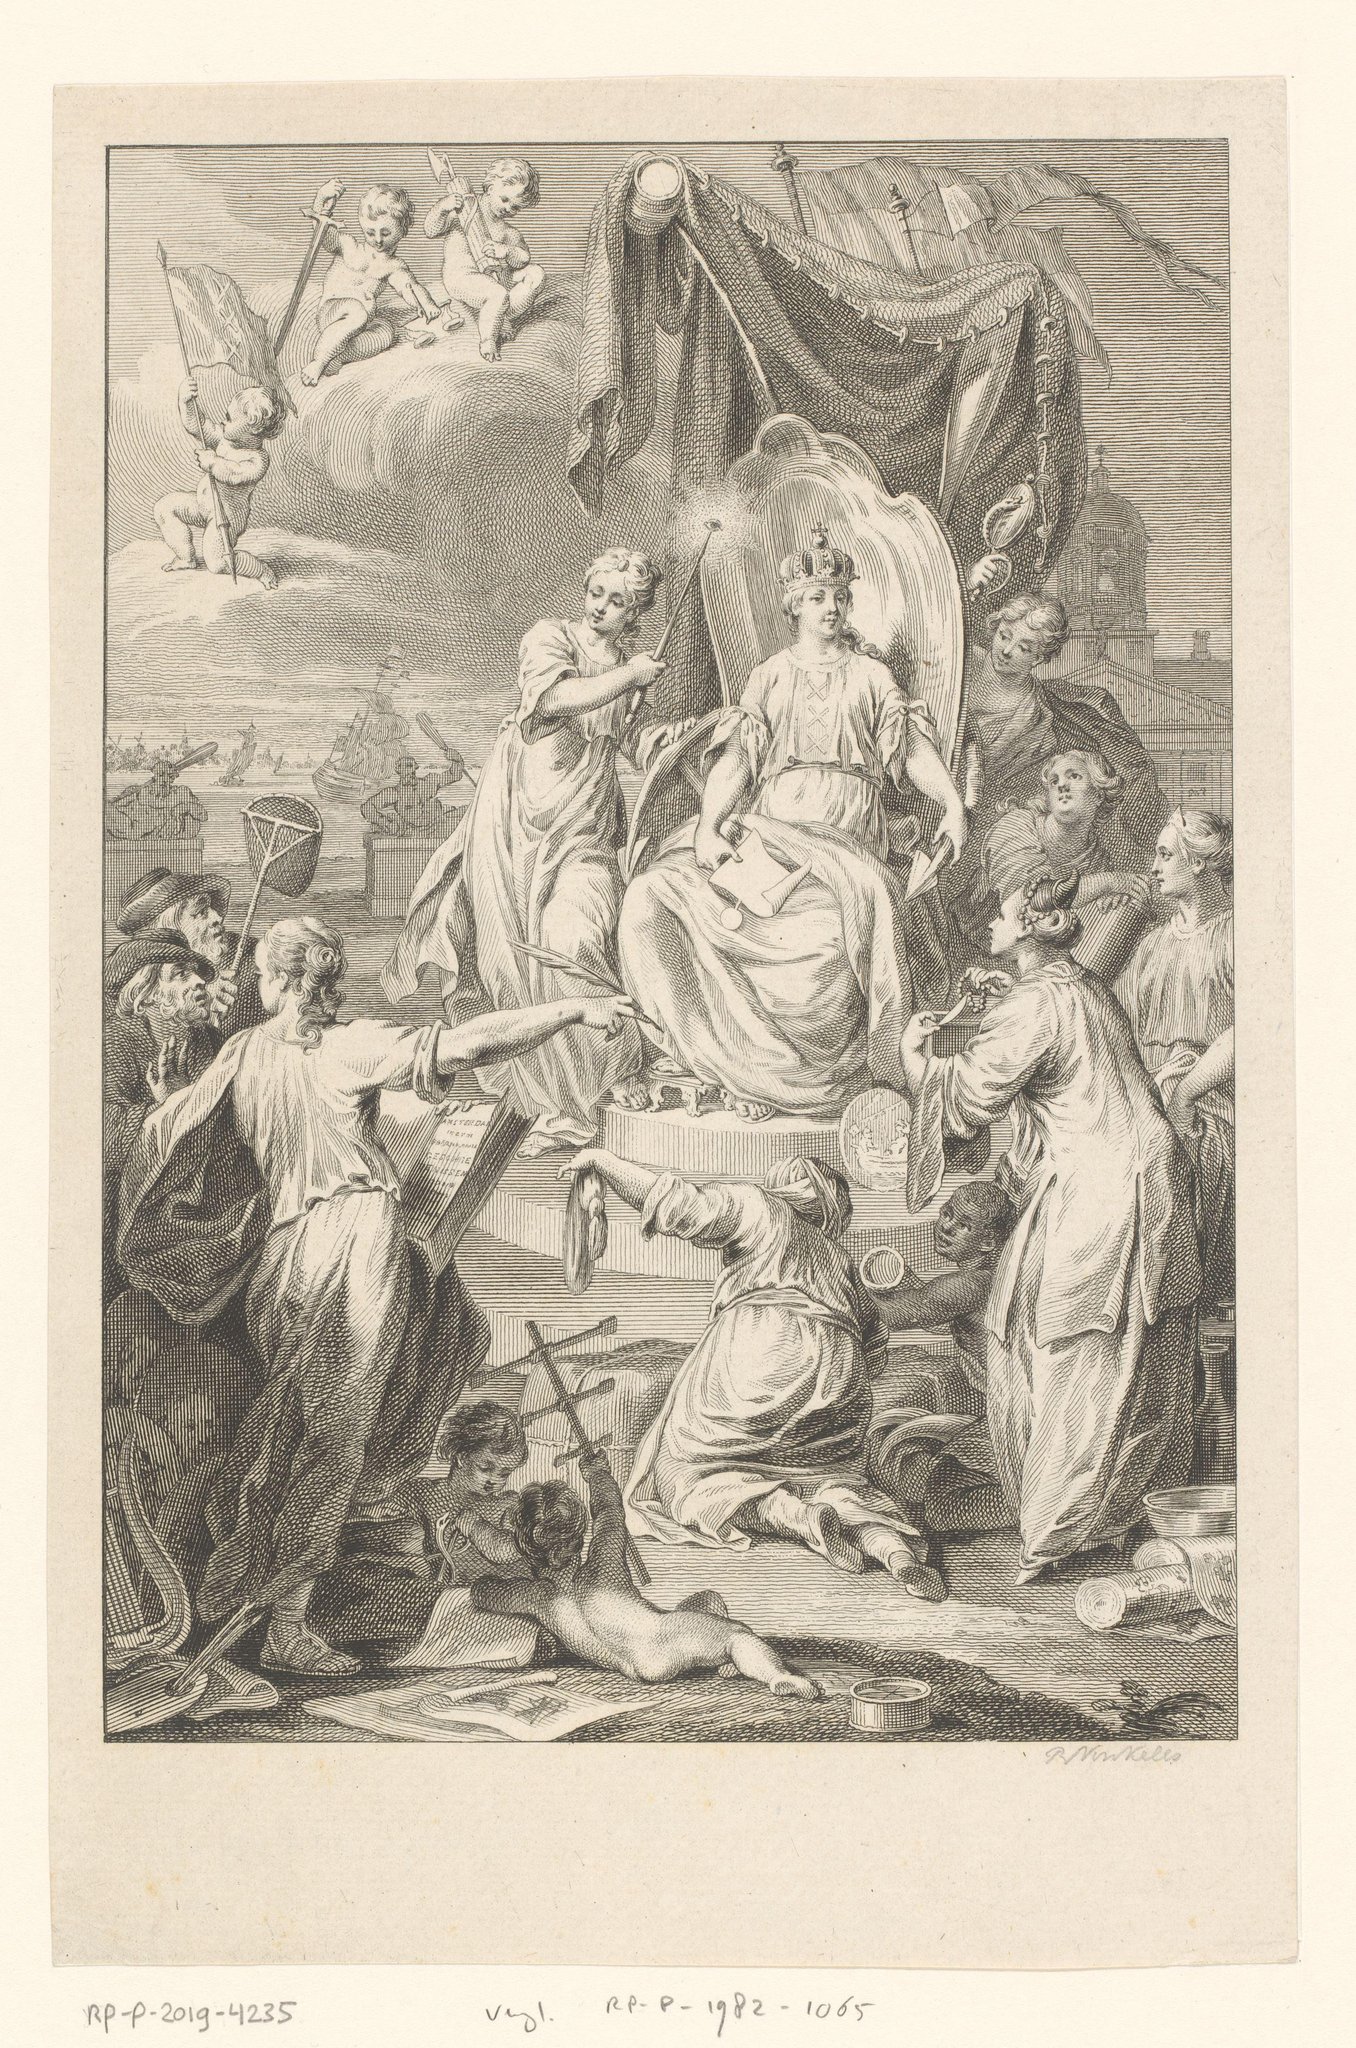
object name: titelblad, titelpagina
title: Titelpagina voor: Jan Wagenaar, Amsterdam in zyne opkomst, aanwas, geschiedenissen, voorregten, koophandel (...), 1767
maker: reinier vinkeles (i)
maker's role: draughtsman, print maker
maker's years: 1741-1816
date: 1767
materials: paper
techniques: etching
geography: amsterdam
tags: prudence, 'prudentia'; 'prudenza' (ripa) ~ one of the four cardinal virtues, personification of a city, town-patron(ess), 'historia'; 'historia' (ripa), amsterdam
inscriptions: collector's mark: Lugt 240, inscription: ‘R Vinkeles’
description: De Amsterdamse gekroonde stedenmaagd zit op een troon, omringd door allegorische figuren. Naast haar staat een vrouwenfiguur met op een staf het Alziend Oog, achter de troon staat Voorzichtigheid met spiegel en slang. Links op de voorgrond Geschiedenis met in haar handen een schrijfveer en een boek. Op de achtergrond het stadhuis op de Dam en beelden van twee riviergoden, de Amstel en het IJ.